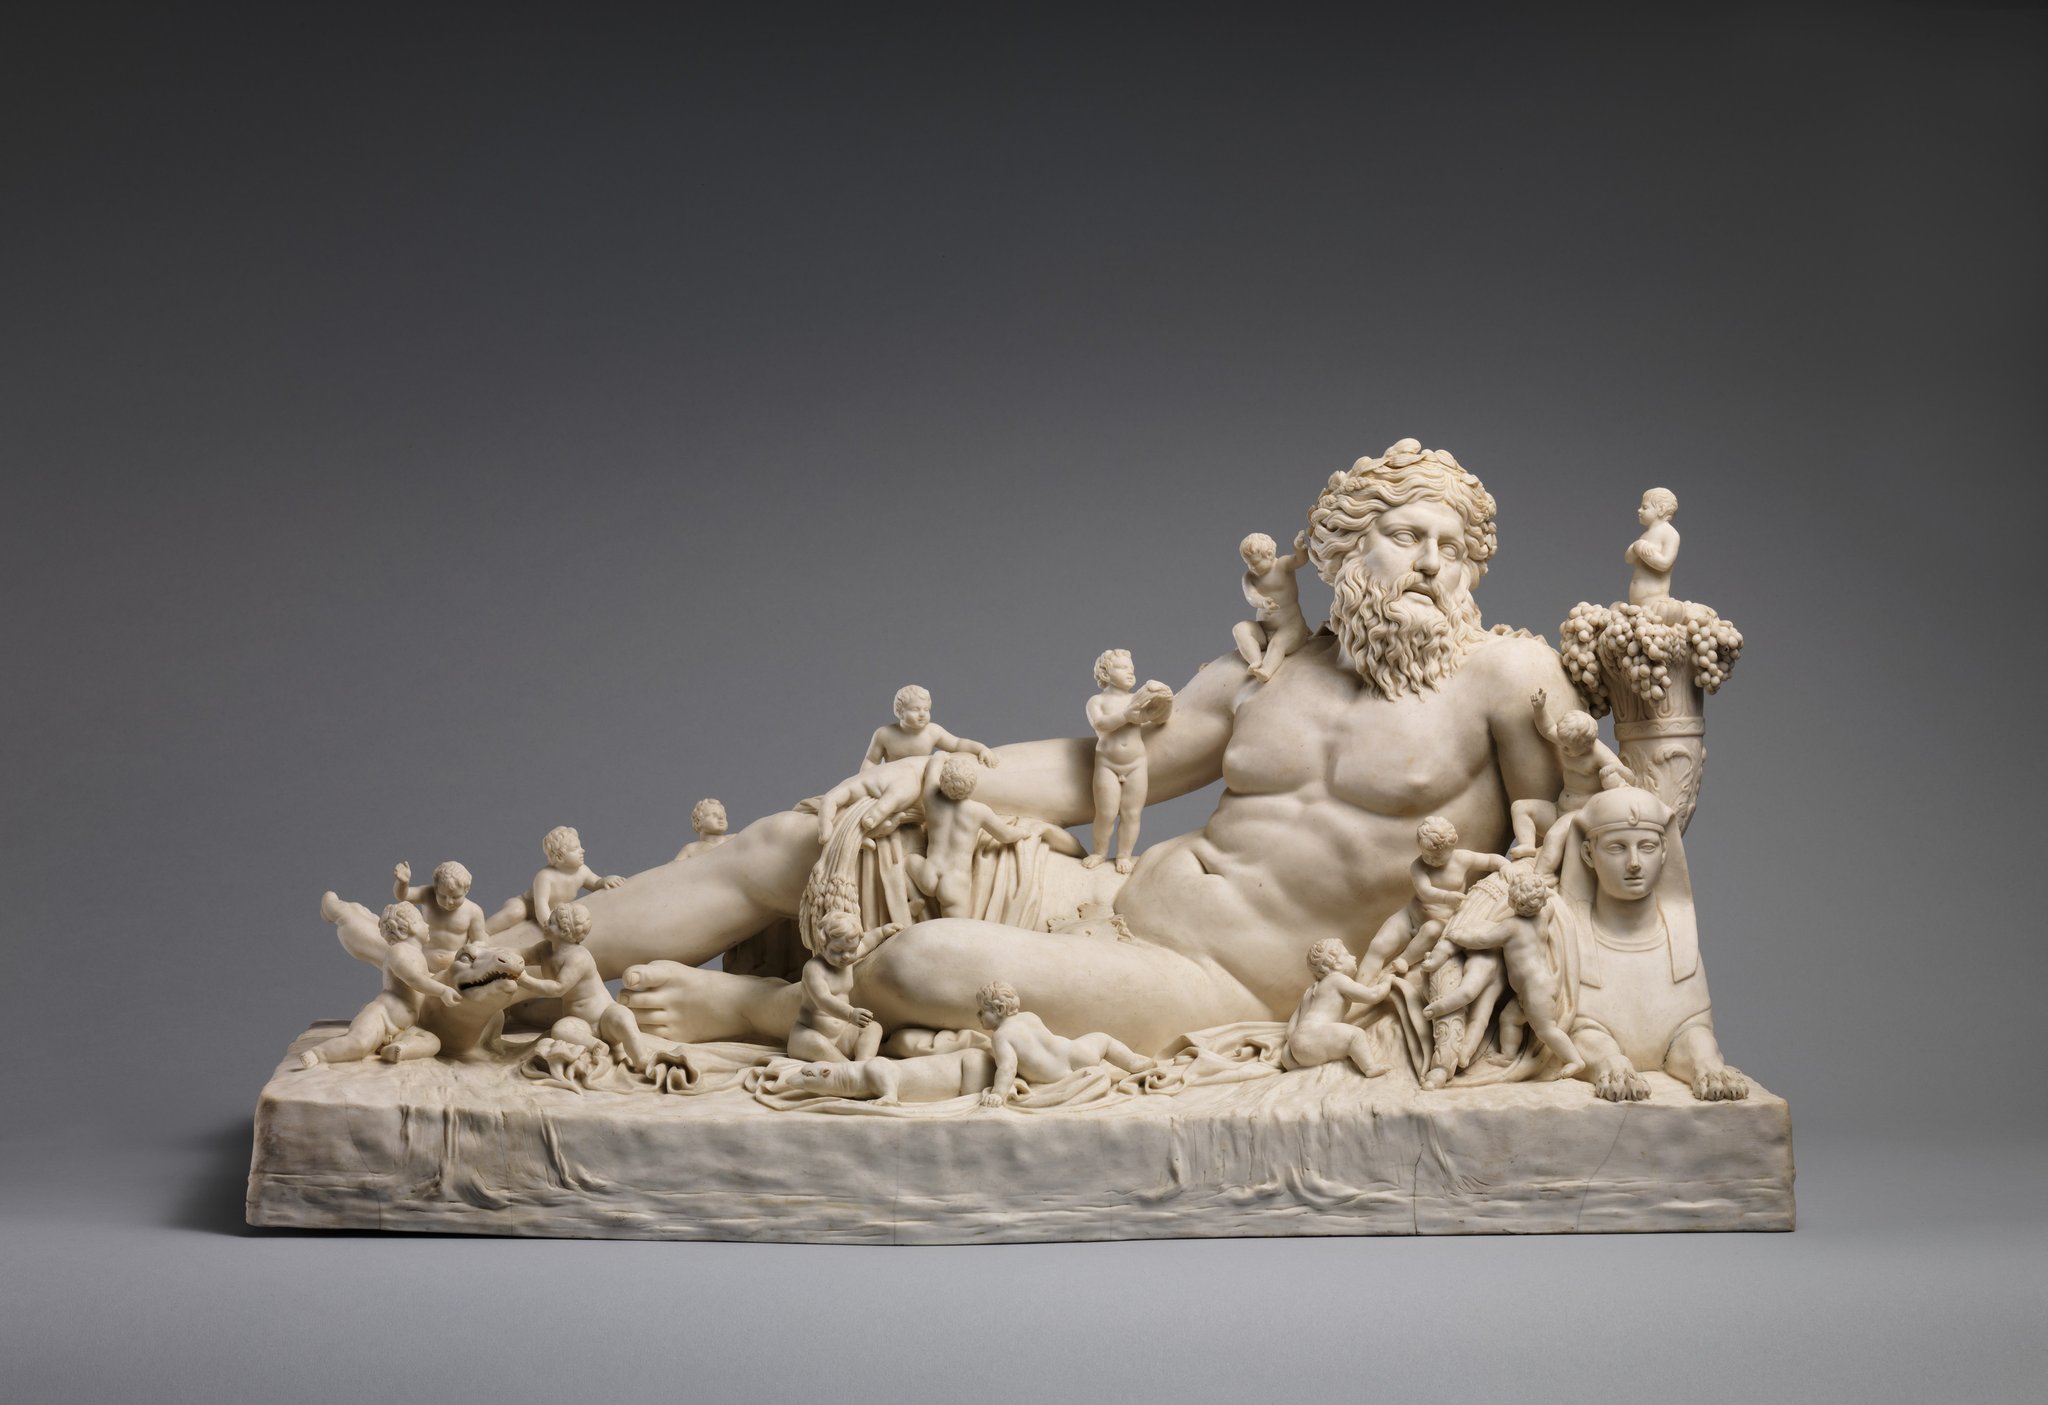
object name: group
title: Personification of the River Nile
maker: giovanni volpato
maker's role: artist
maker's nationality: italian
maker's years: 1732-1803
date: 1785-1795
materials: biscuit, paste, porcelain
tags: boys,men,sphinx,crocodiles